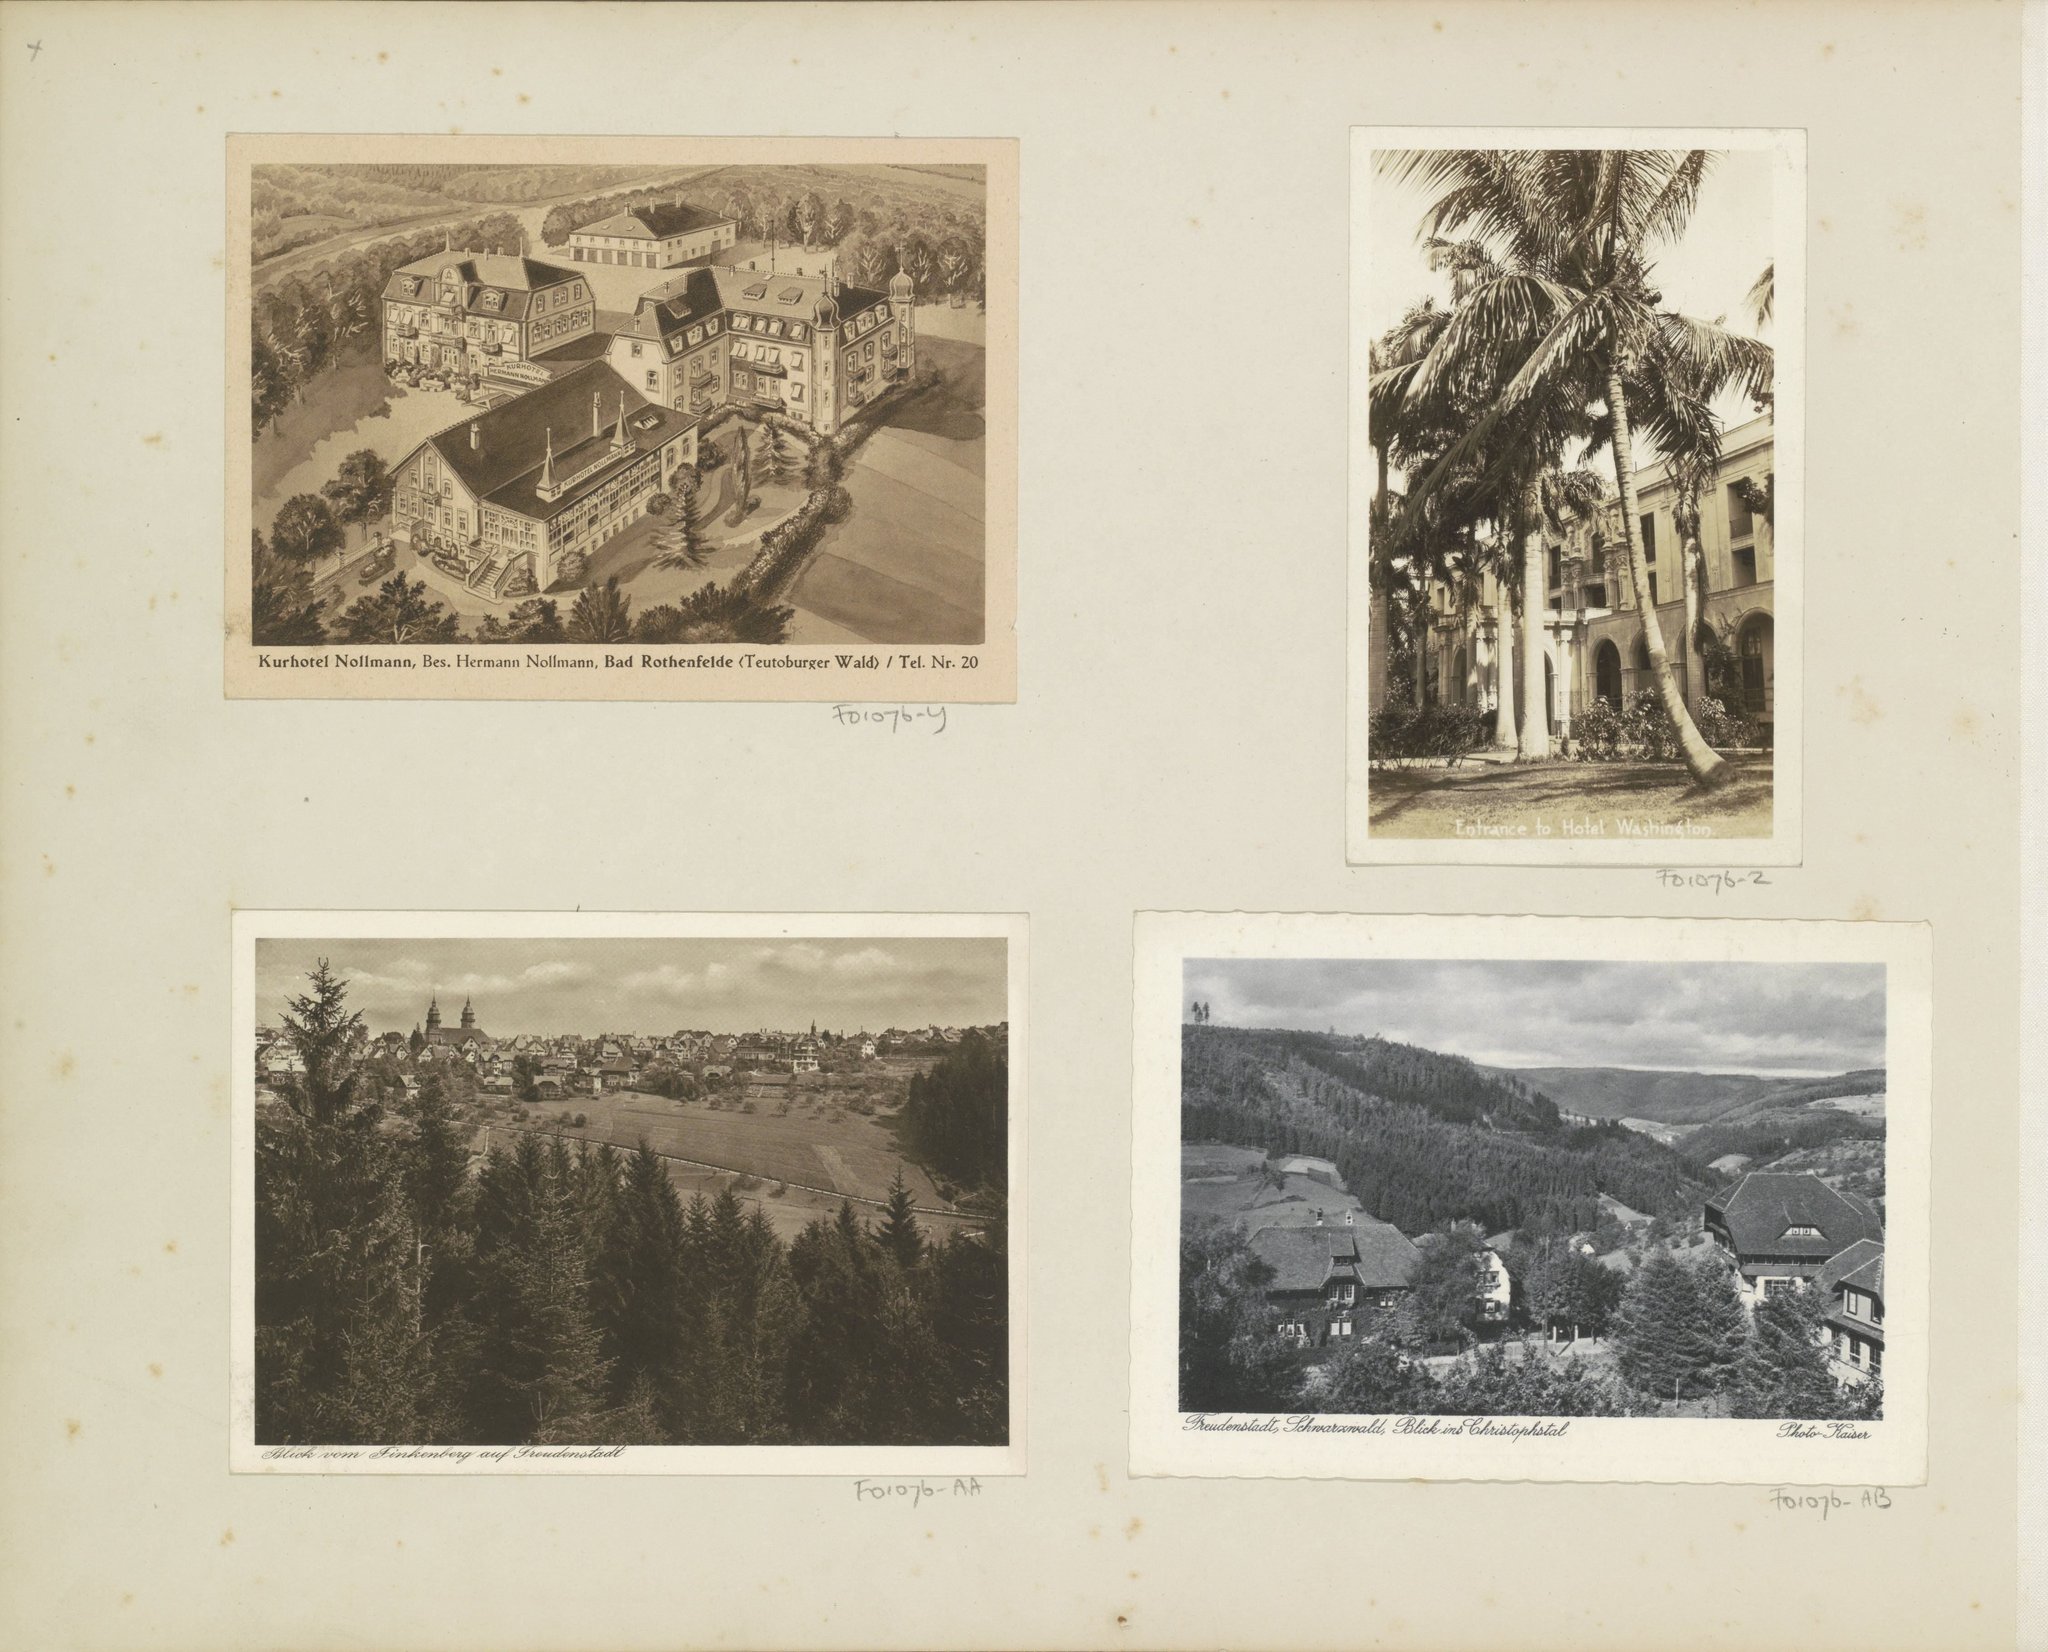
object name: album leaf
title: Gezicht op het Christophstal bij Freudenstadt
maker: kaiser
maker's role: fotograaf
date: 1900-1940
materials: cardboard, paper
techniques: rotogravure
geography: freudenstadt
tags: dale, valley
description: Onderdeel van Album met foto's van spoorwegen in Nederlands-Indië en prentbriefkaarten.